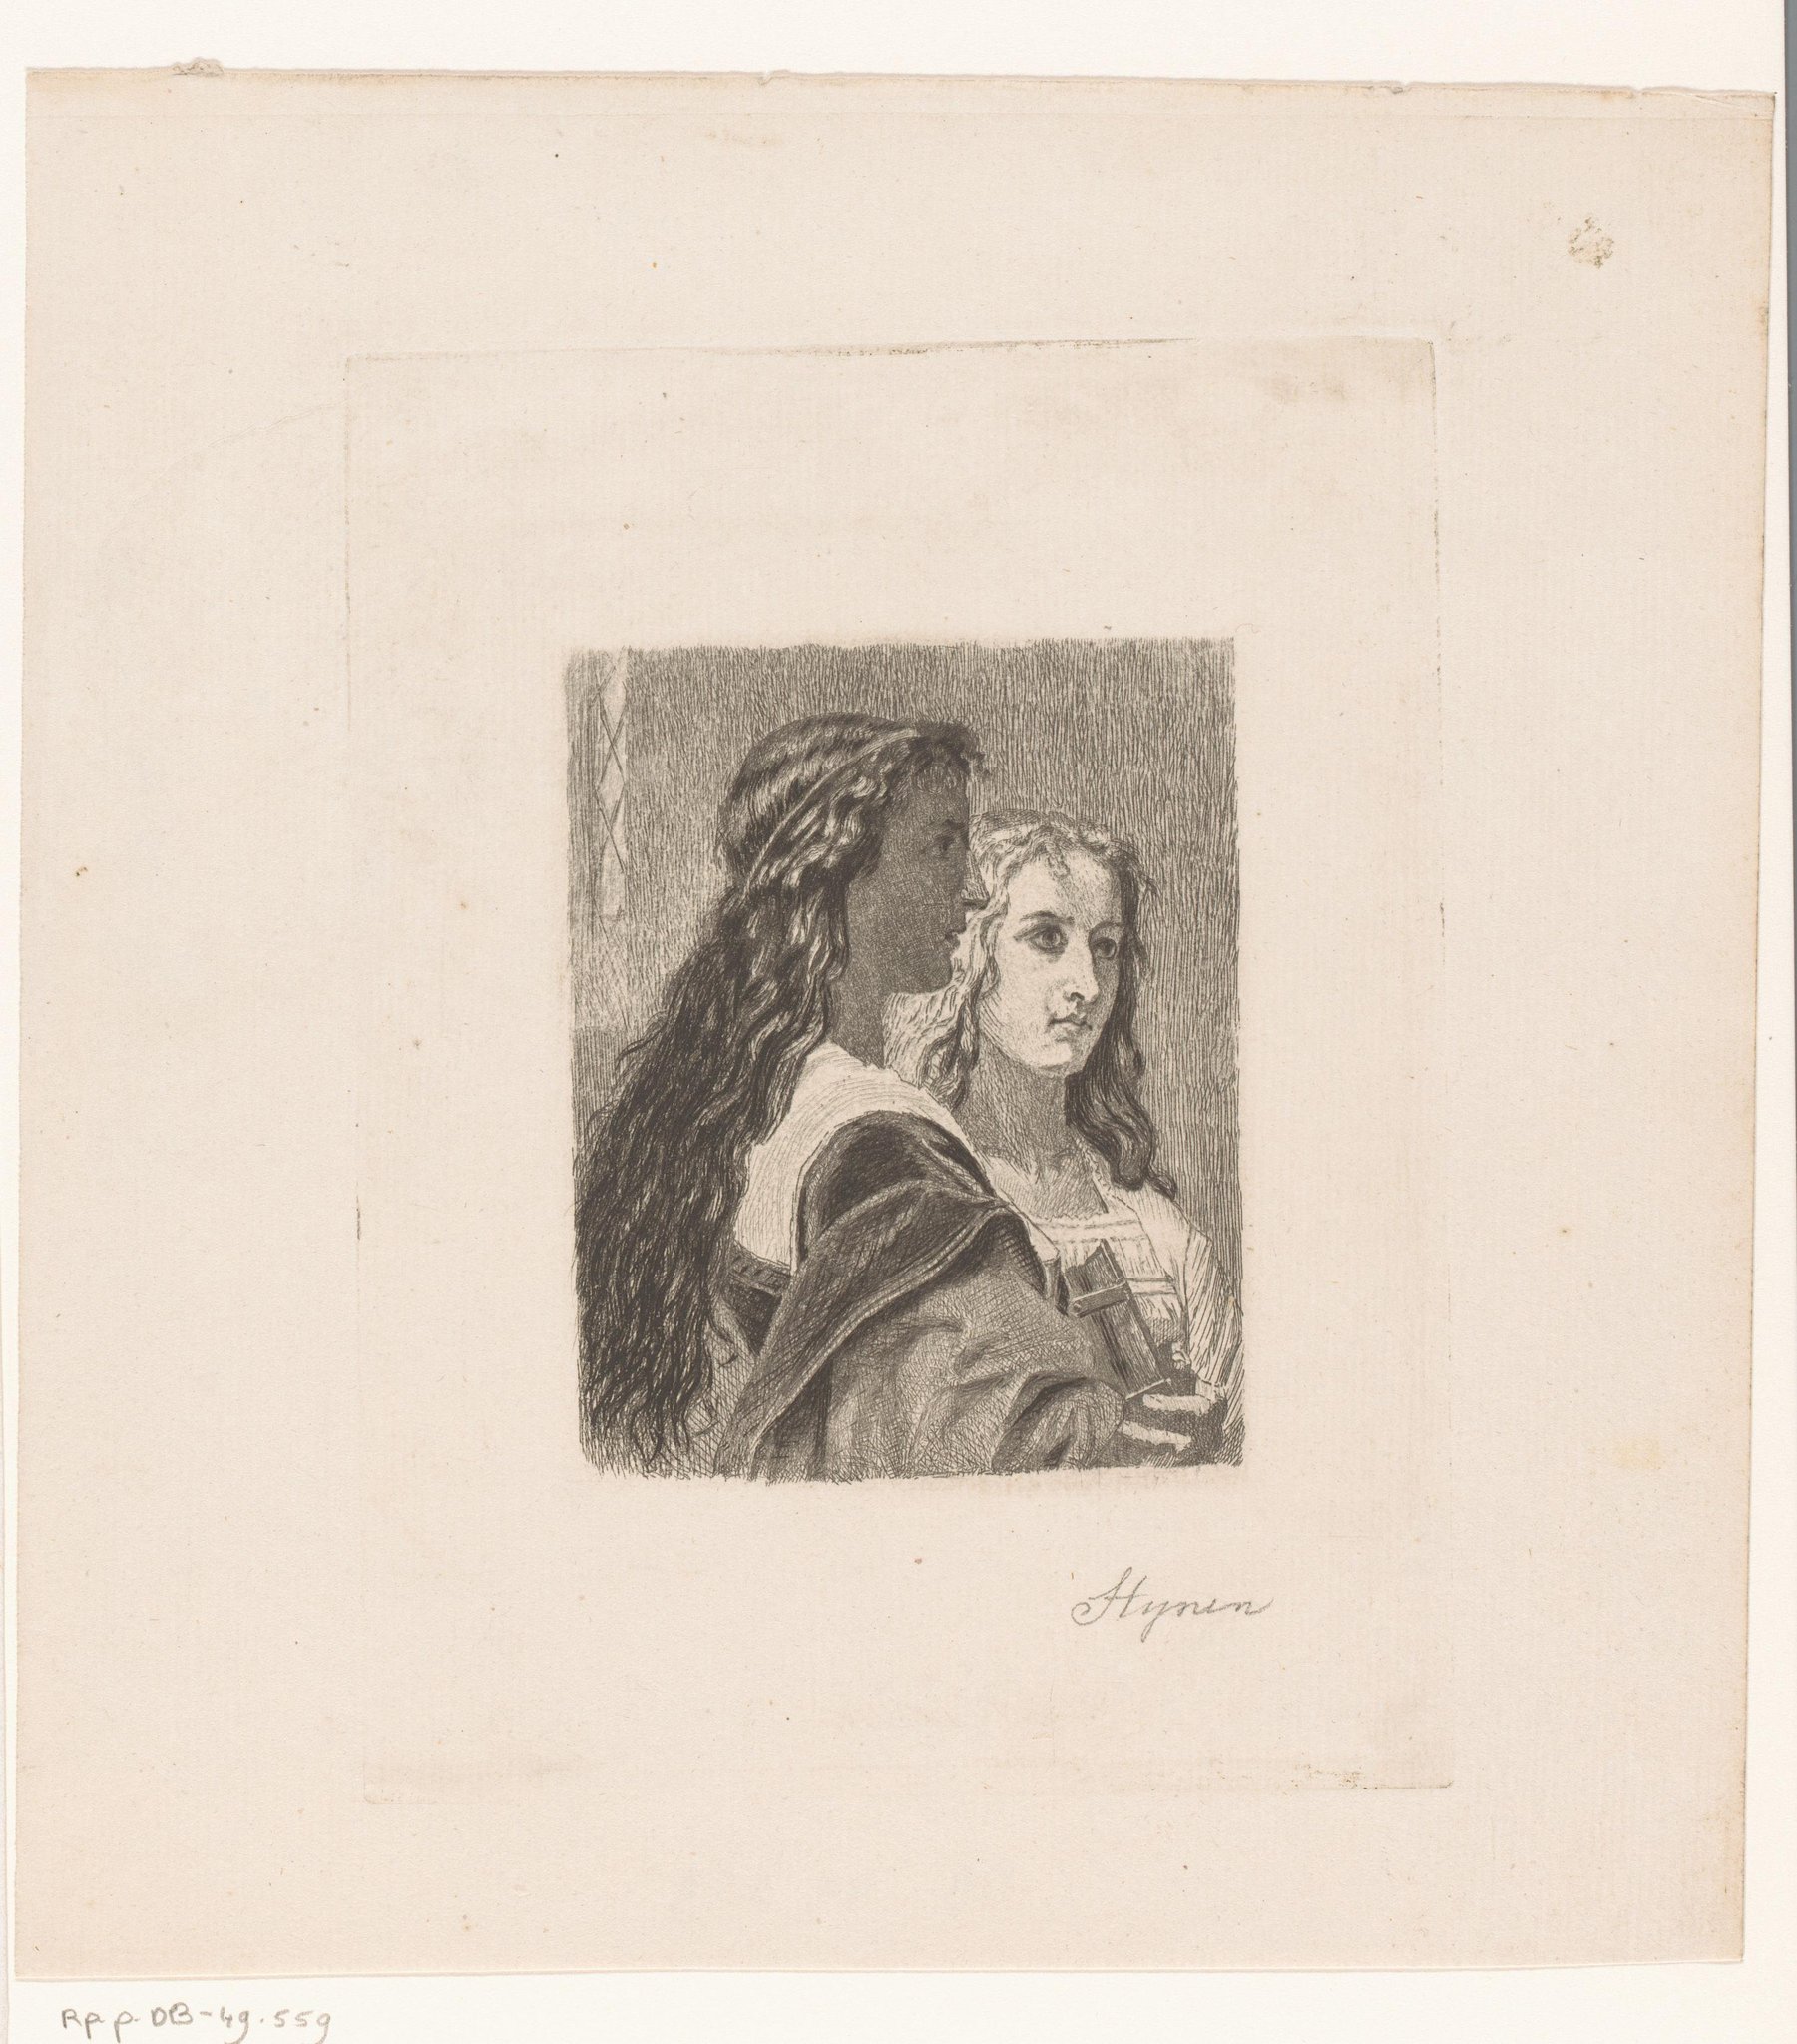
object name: print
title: Twee figuren, mogelijk Romeo en Julia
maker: joseph paul steynen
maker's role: print maker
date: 1850-1913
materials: paper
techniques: etching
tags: romeo, juliet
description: In de inventaris getiteld: Romeo en Julia.